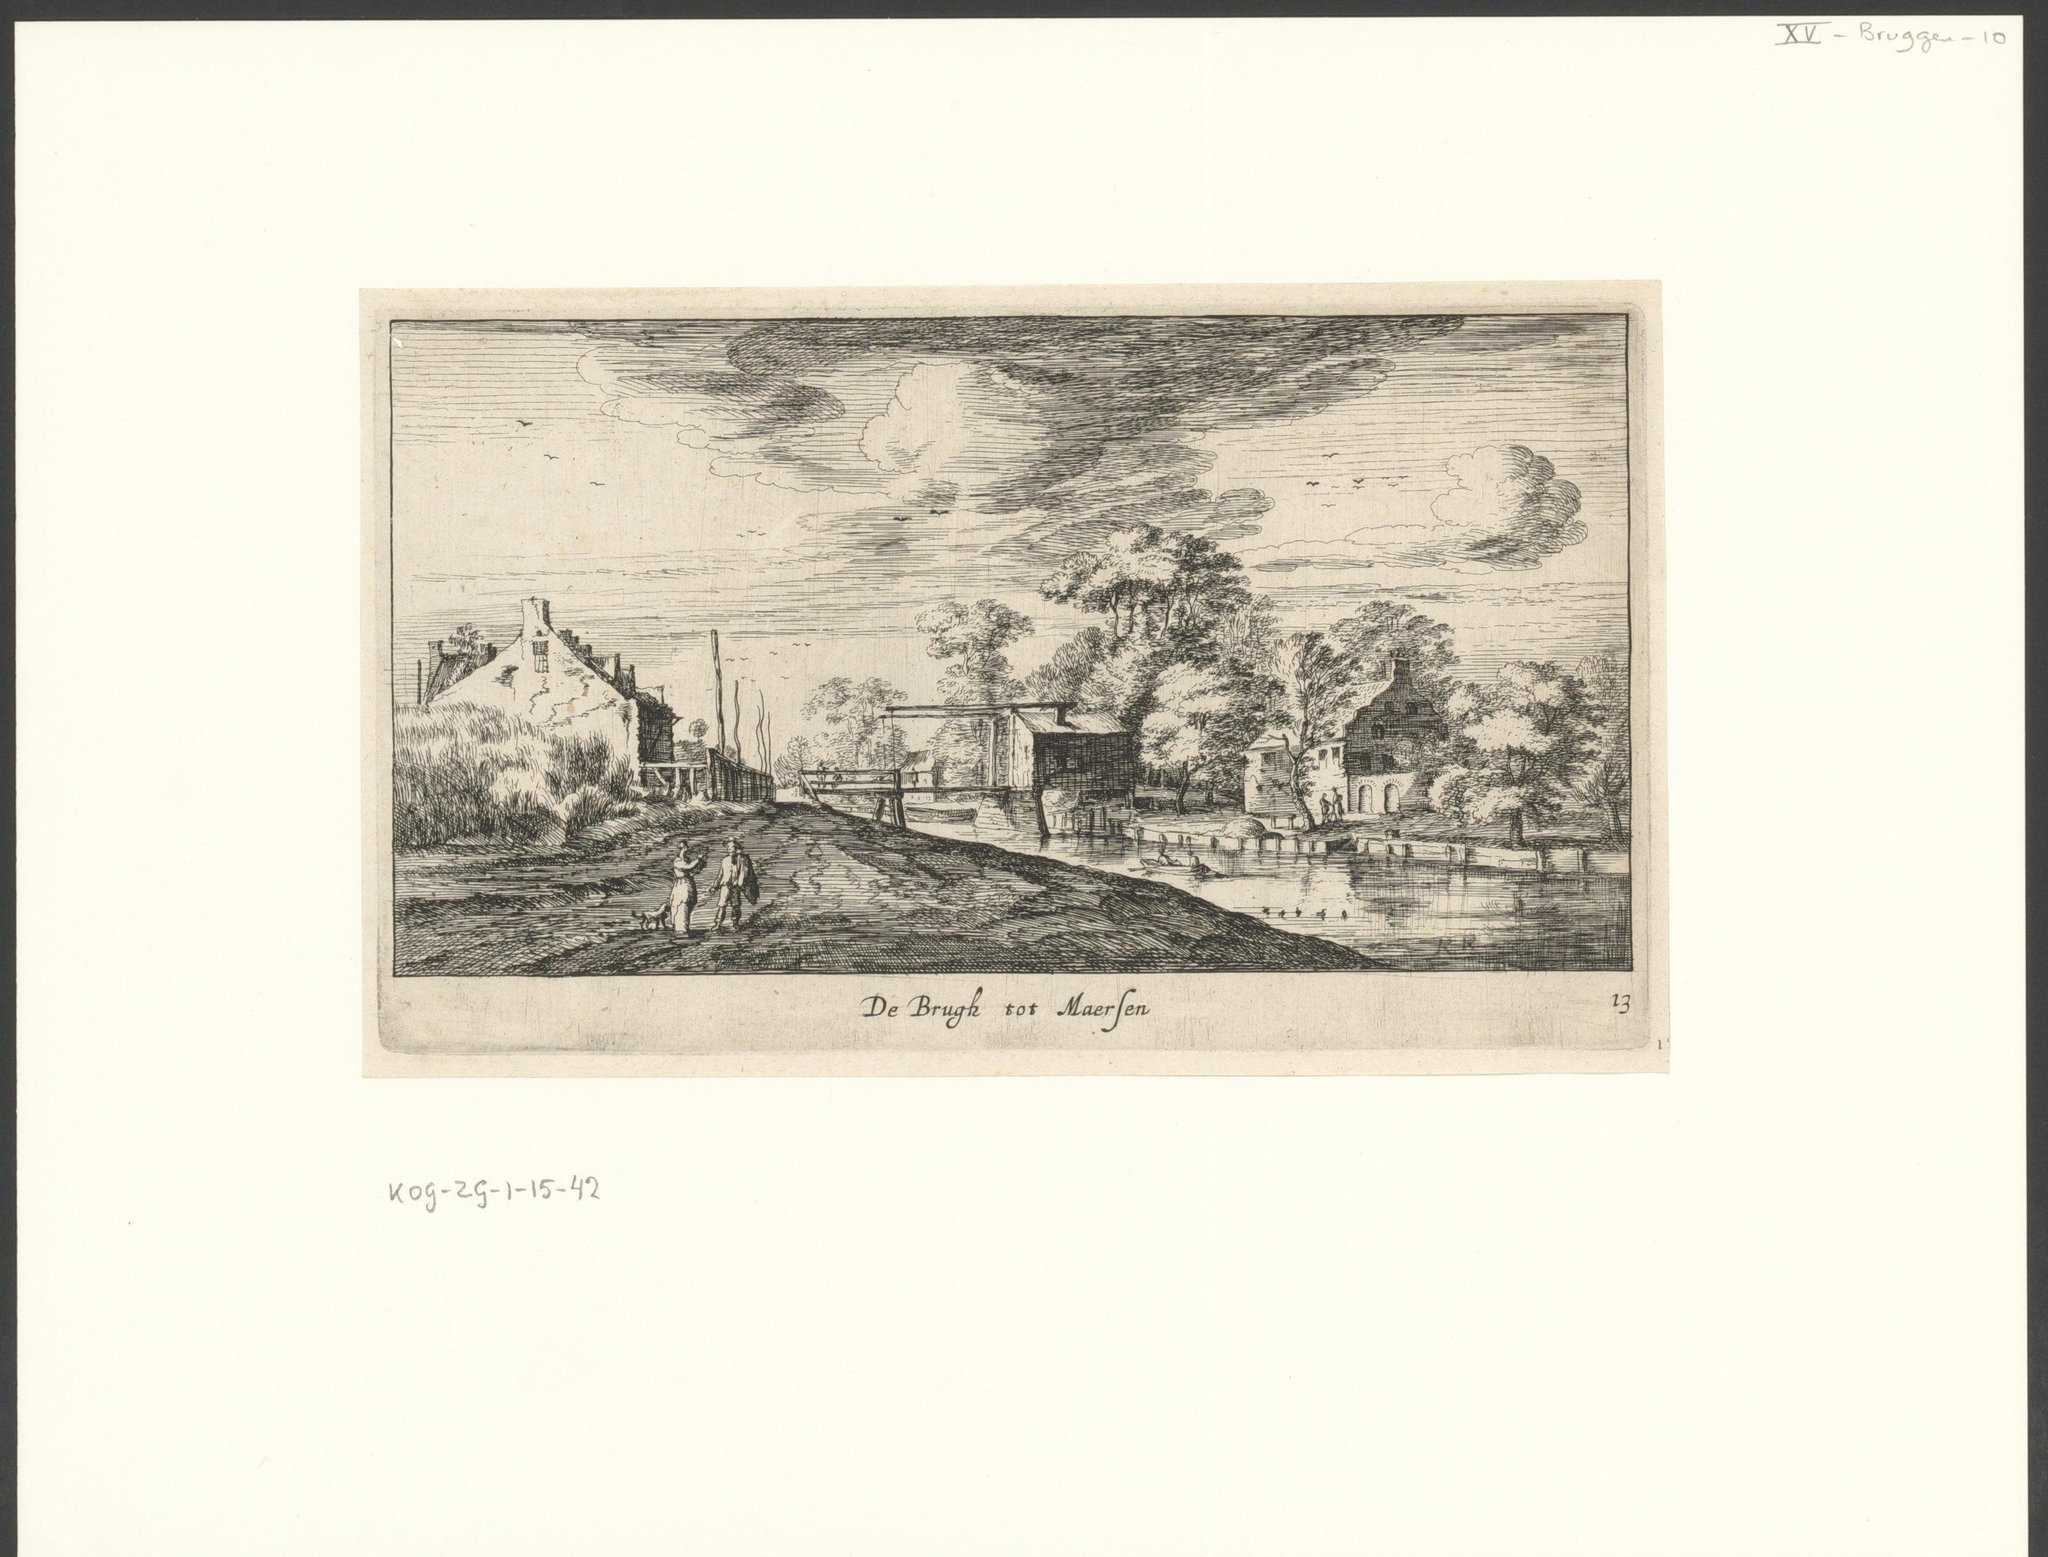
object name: print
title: Brug bij Maarssen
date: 1637-1652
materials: paper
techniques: engraving, etching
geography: amsterdam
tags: standing figure (+ two persons), rowing-boat, canoe, etc., bridge, maarssen, vecht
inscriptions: collector's mark: Lugt 1641, stamp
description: Gezicht op een ophaalbrug bij Maarssen met rechts de rivier de Vecht. Rechtsonder genummerd: 13. Onderwerpsrubrieken binnen de Atlas Zeden en Gewoonten: Handel, nijverheid en verkeer, Bruggen.